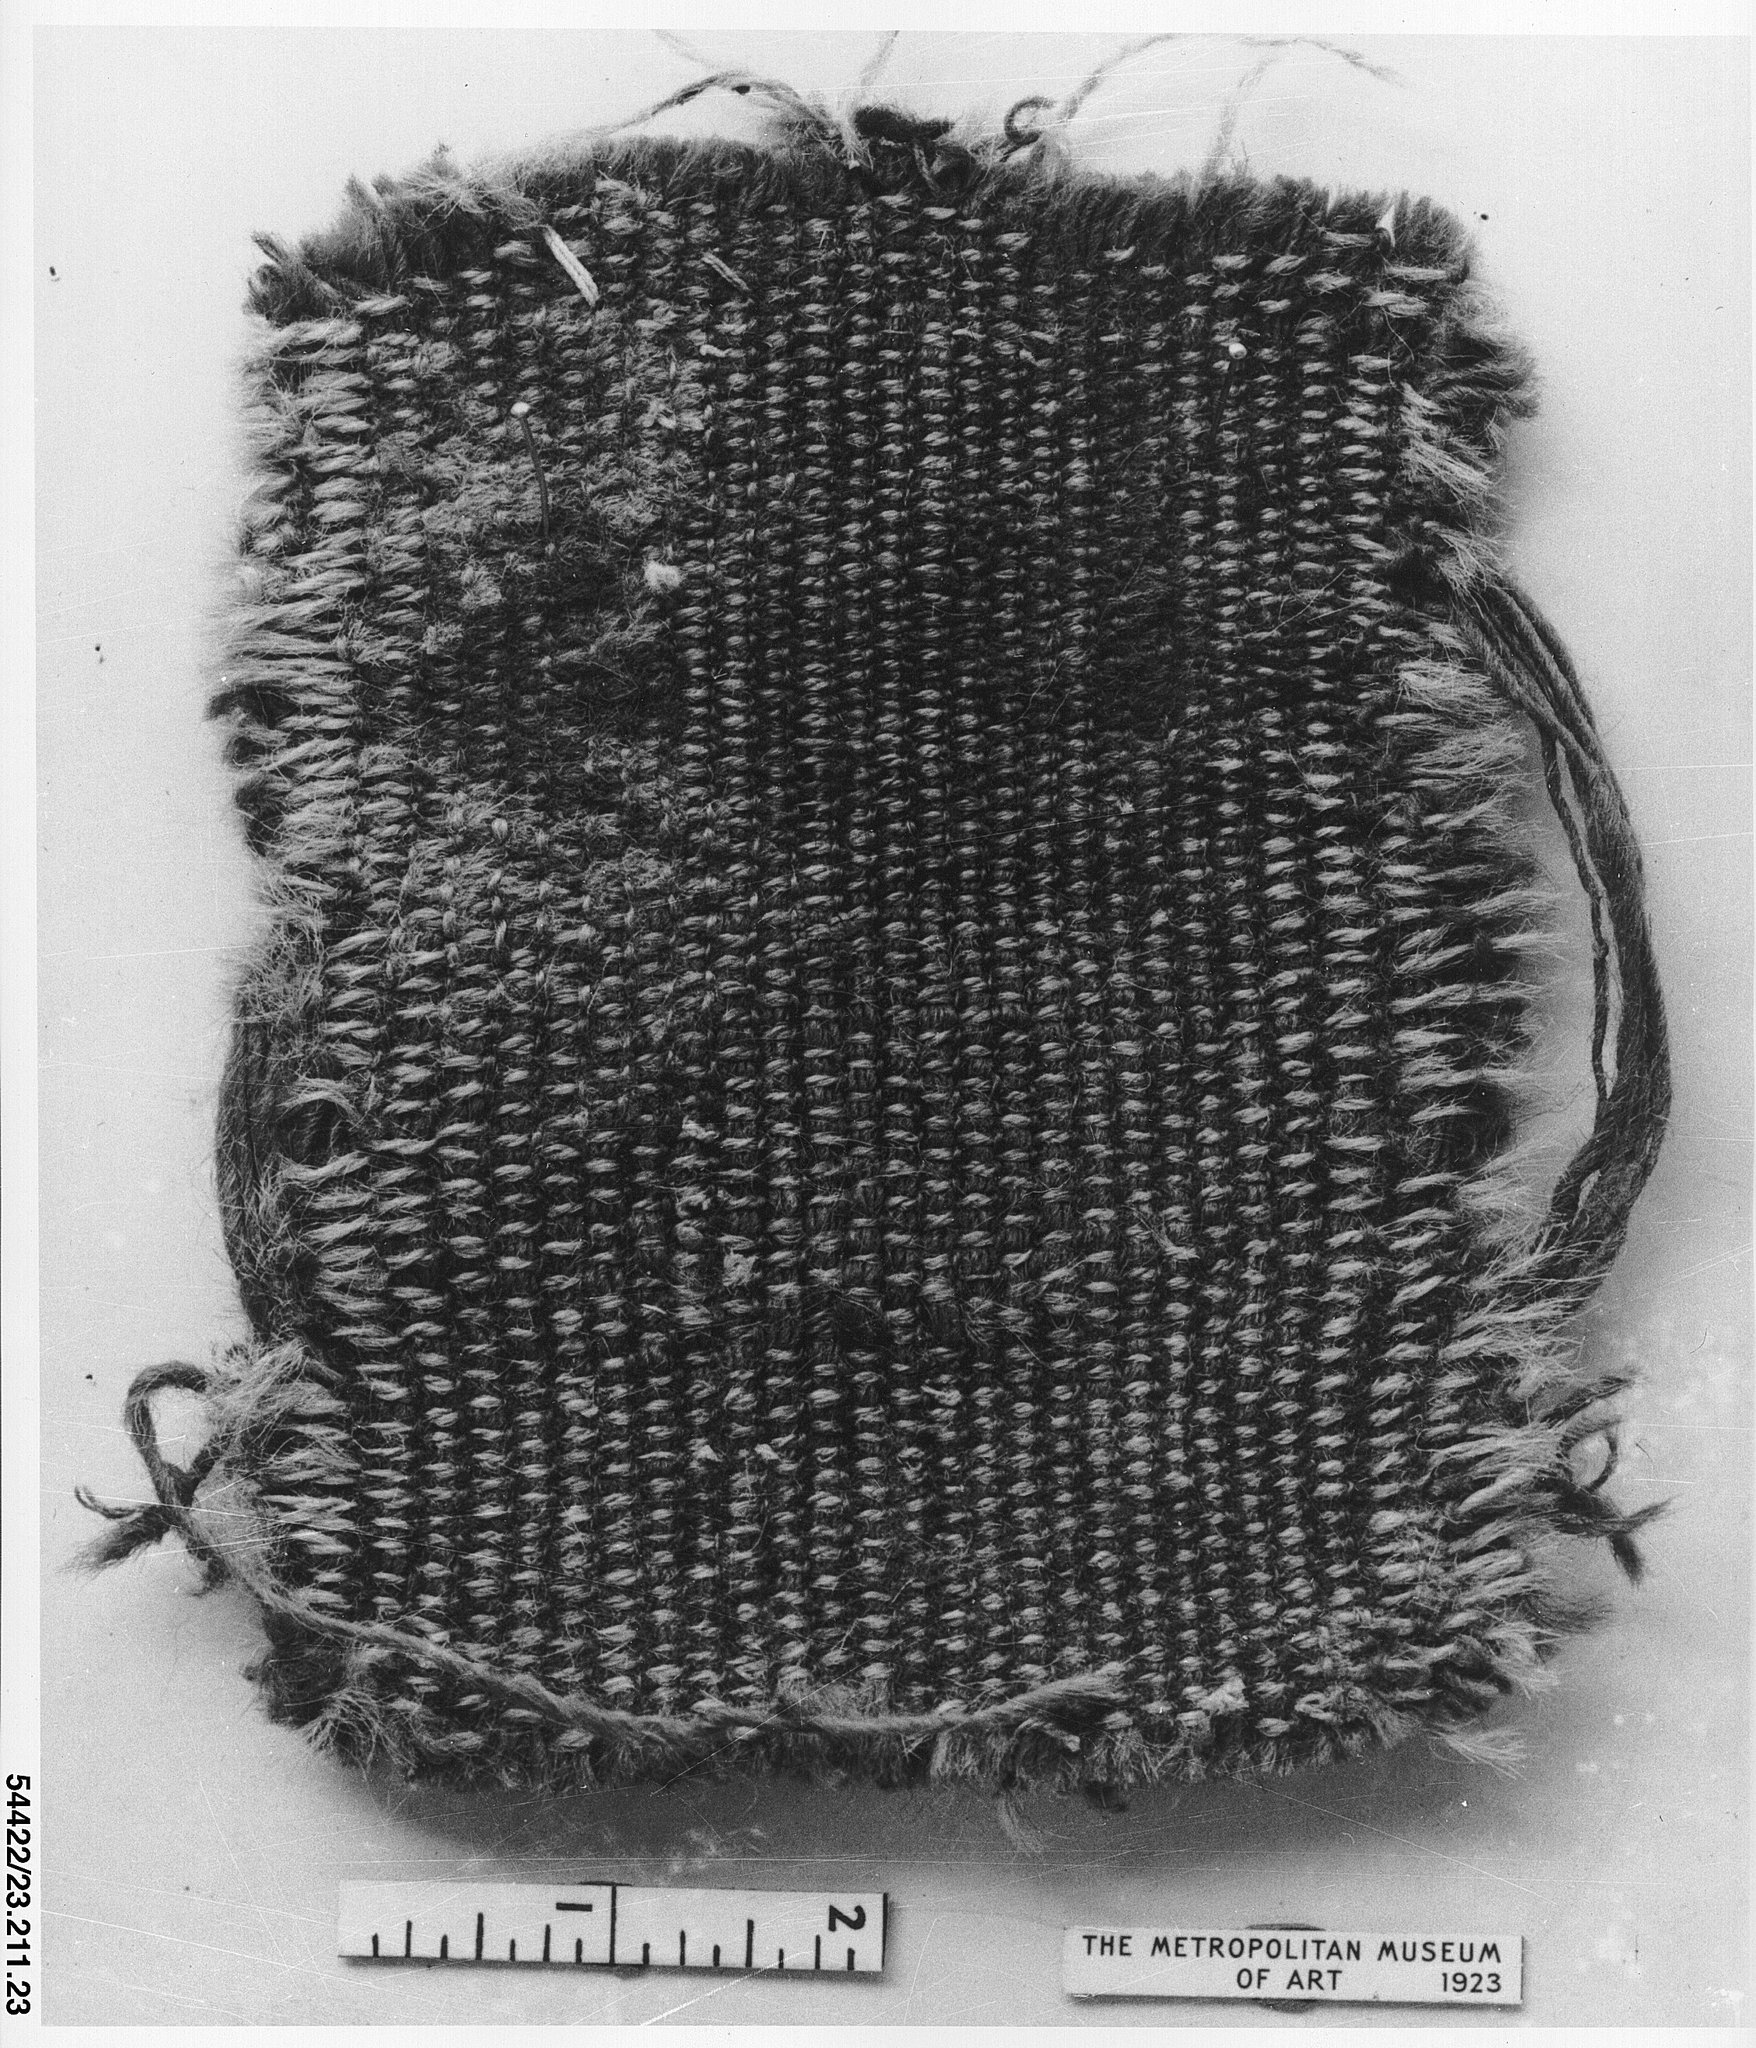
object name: rug fragment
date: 1501-1600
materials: wool